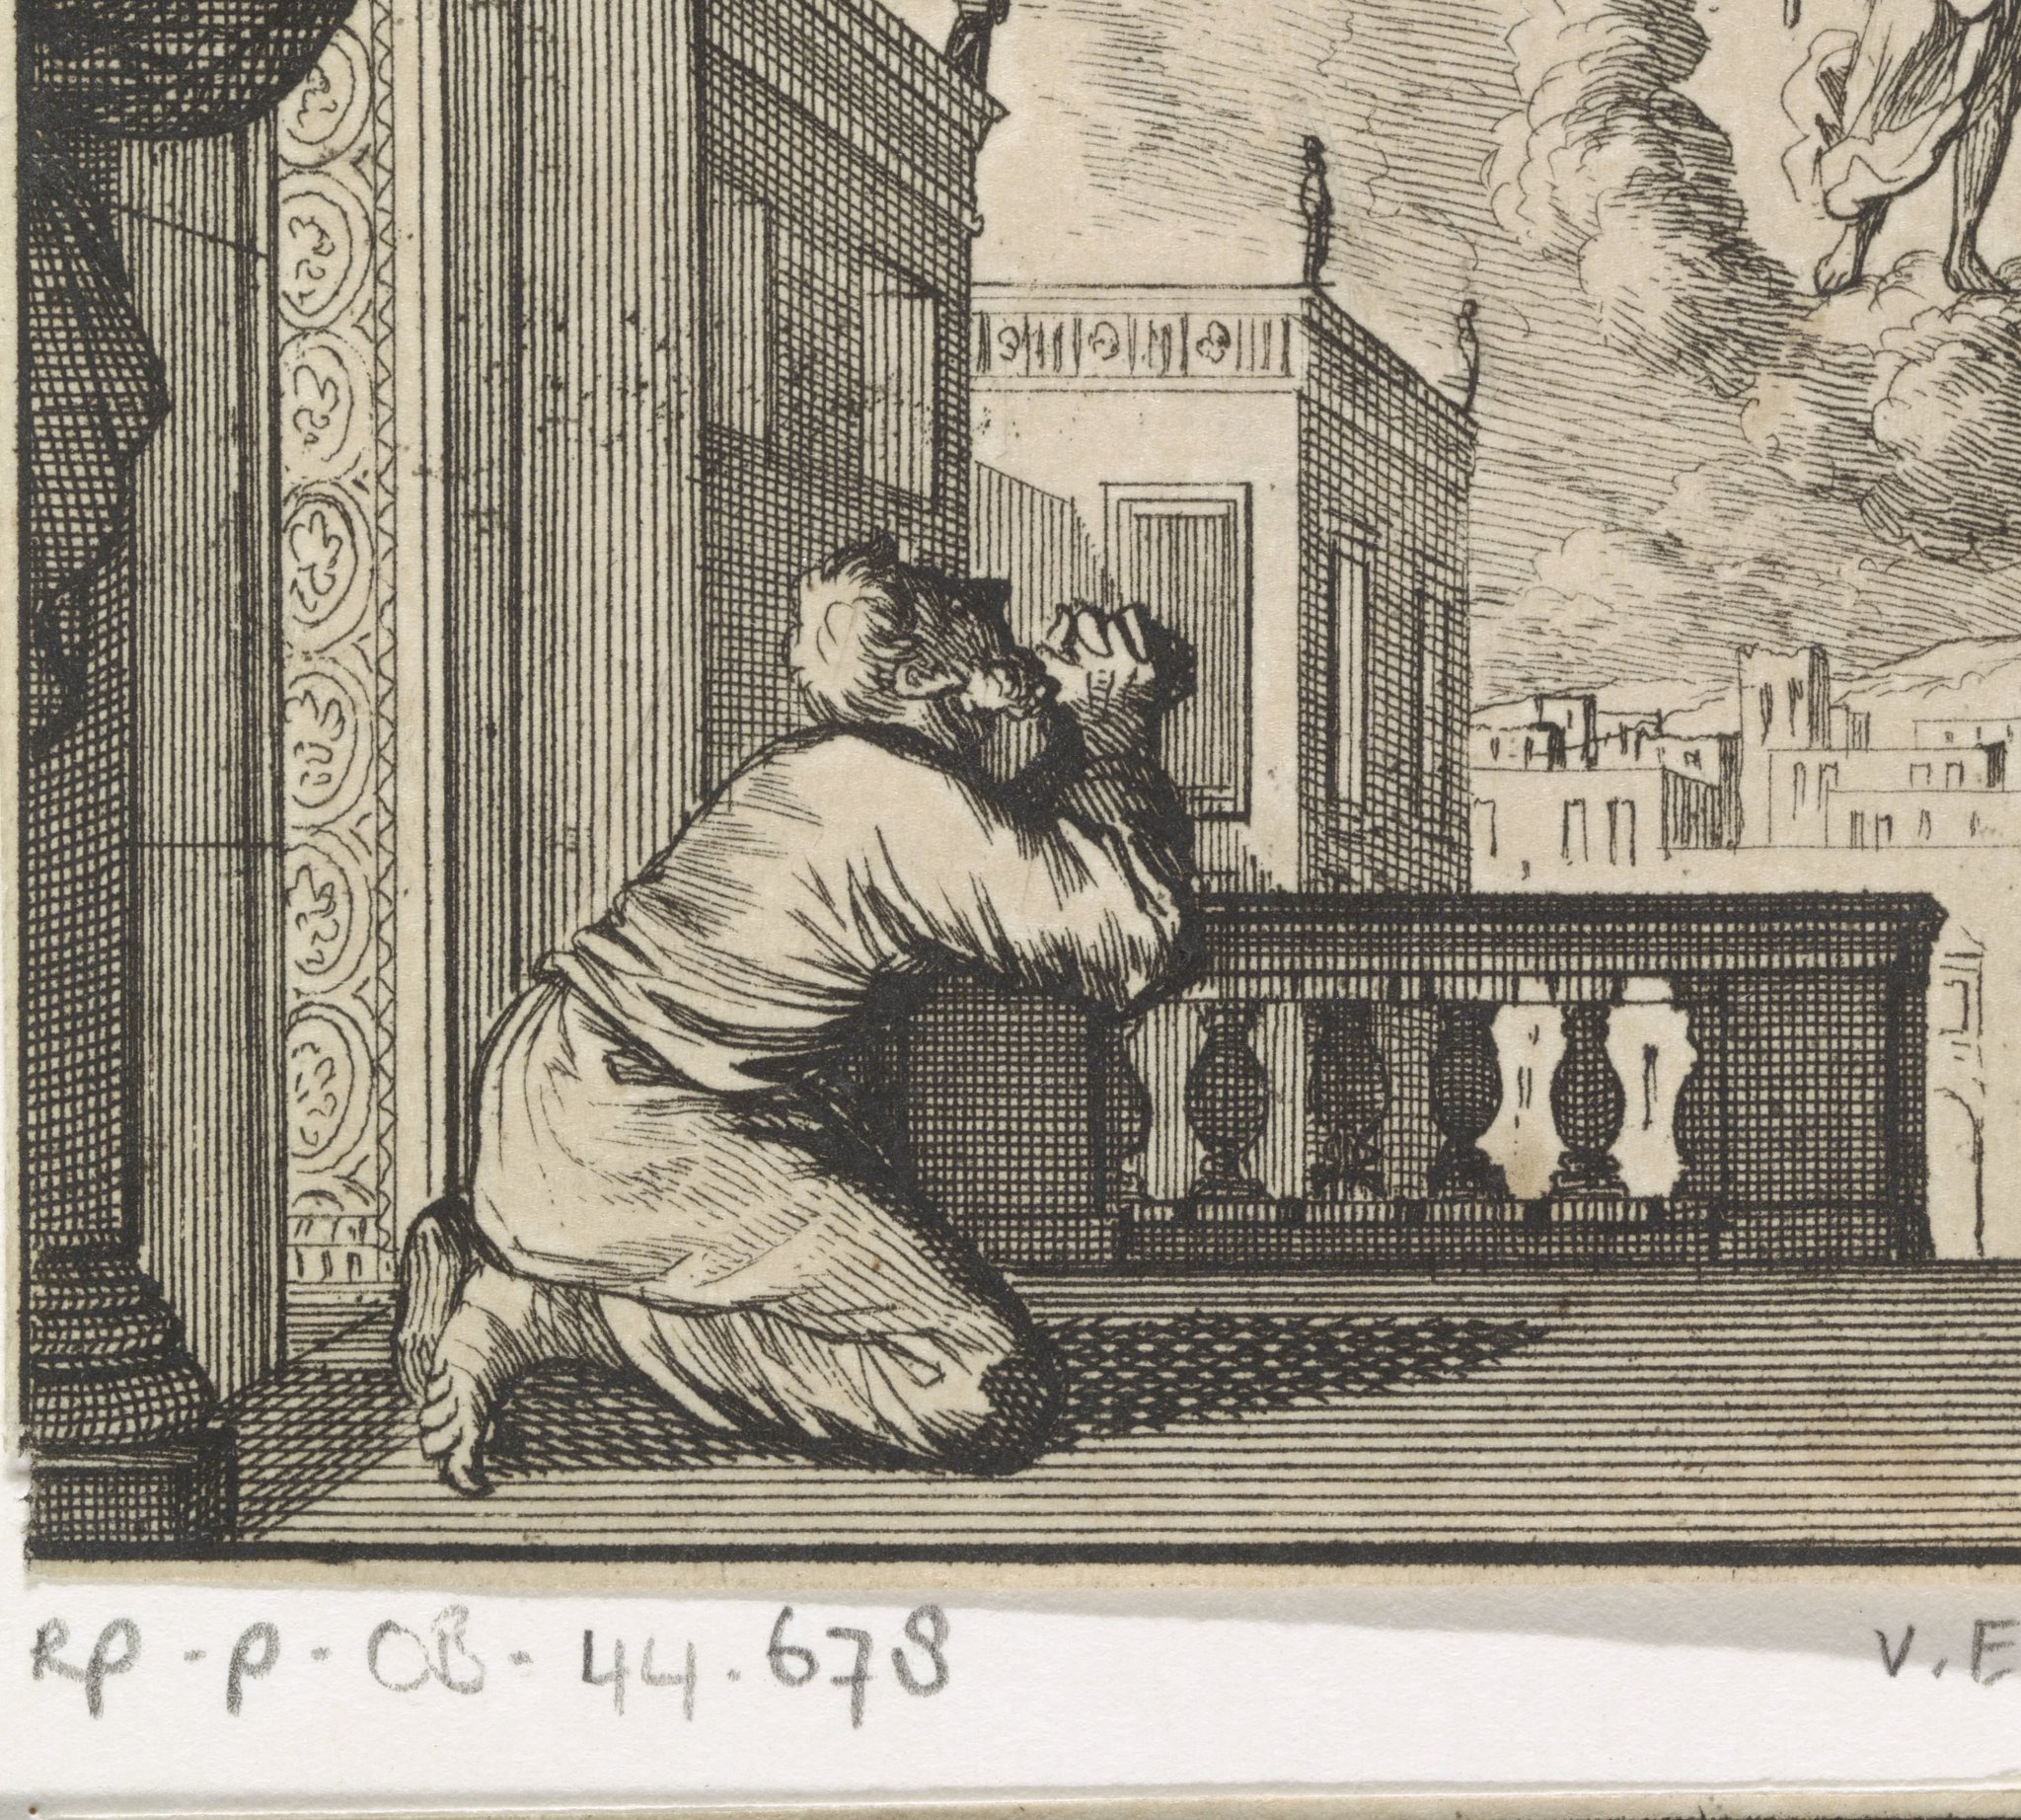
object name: print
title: Koning David ziet de engel des doods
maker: caspar luyken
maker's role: draughtsman, print maker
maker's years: 1672-1708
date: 1698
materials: paper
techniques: etching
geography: amsterdam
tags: god punishes israel with three days of plague; the avenging angel with his sword drawn goes through the land; seventy thousand men are killed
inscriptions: collector's mark: Lugt 2228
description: Proefdruk van illustratie uit: Josephus, Flavius. XX. boeken van de oude geschiedenissen der joden, 4 delen. Amsterdam: Barent Visscher, Willem de Coup, Willem van Lamsveld, Andries van Damme, 1698, dl. I.